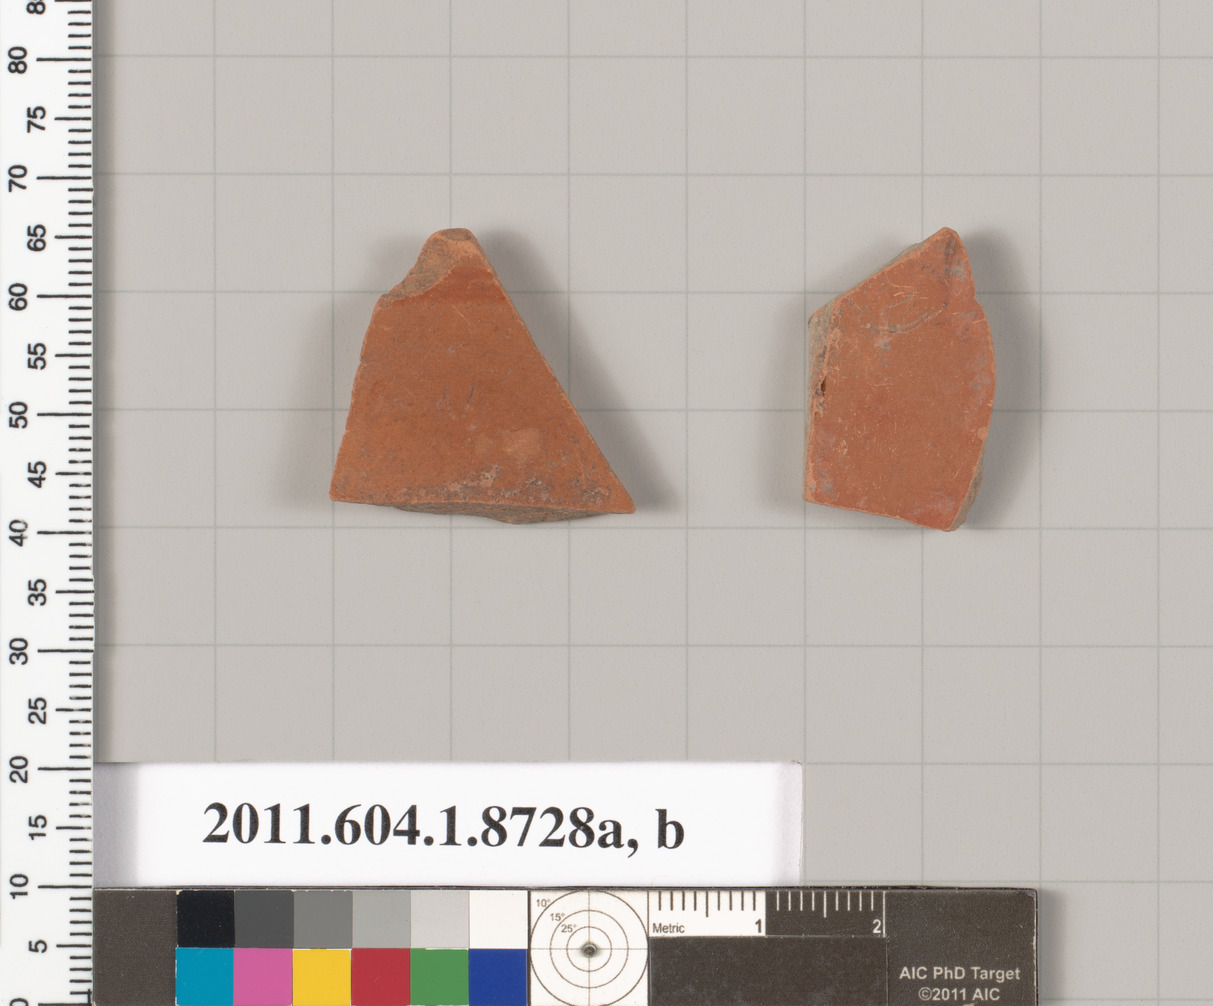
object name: kylix fragment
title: Terracotta fragments of kylikes (drinking cups)?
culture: greek, attic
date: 600-401 BCE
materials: terracotta